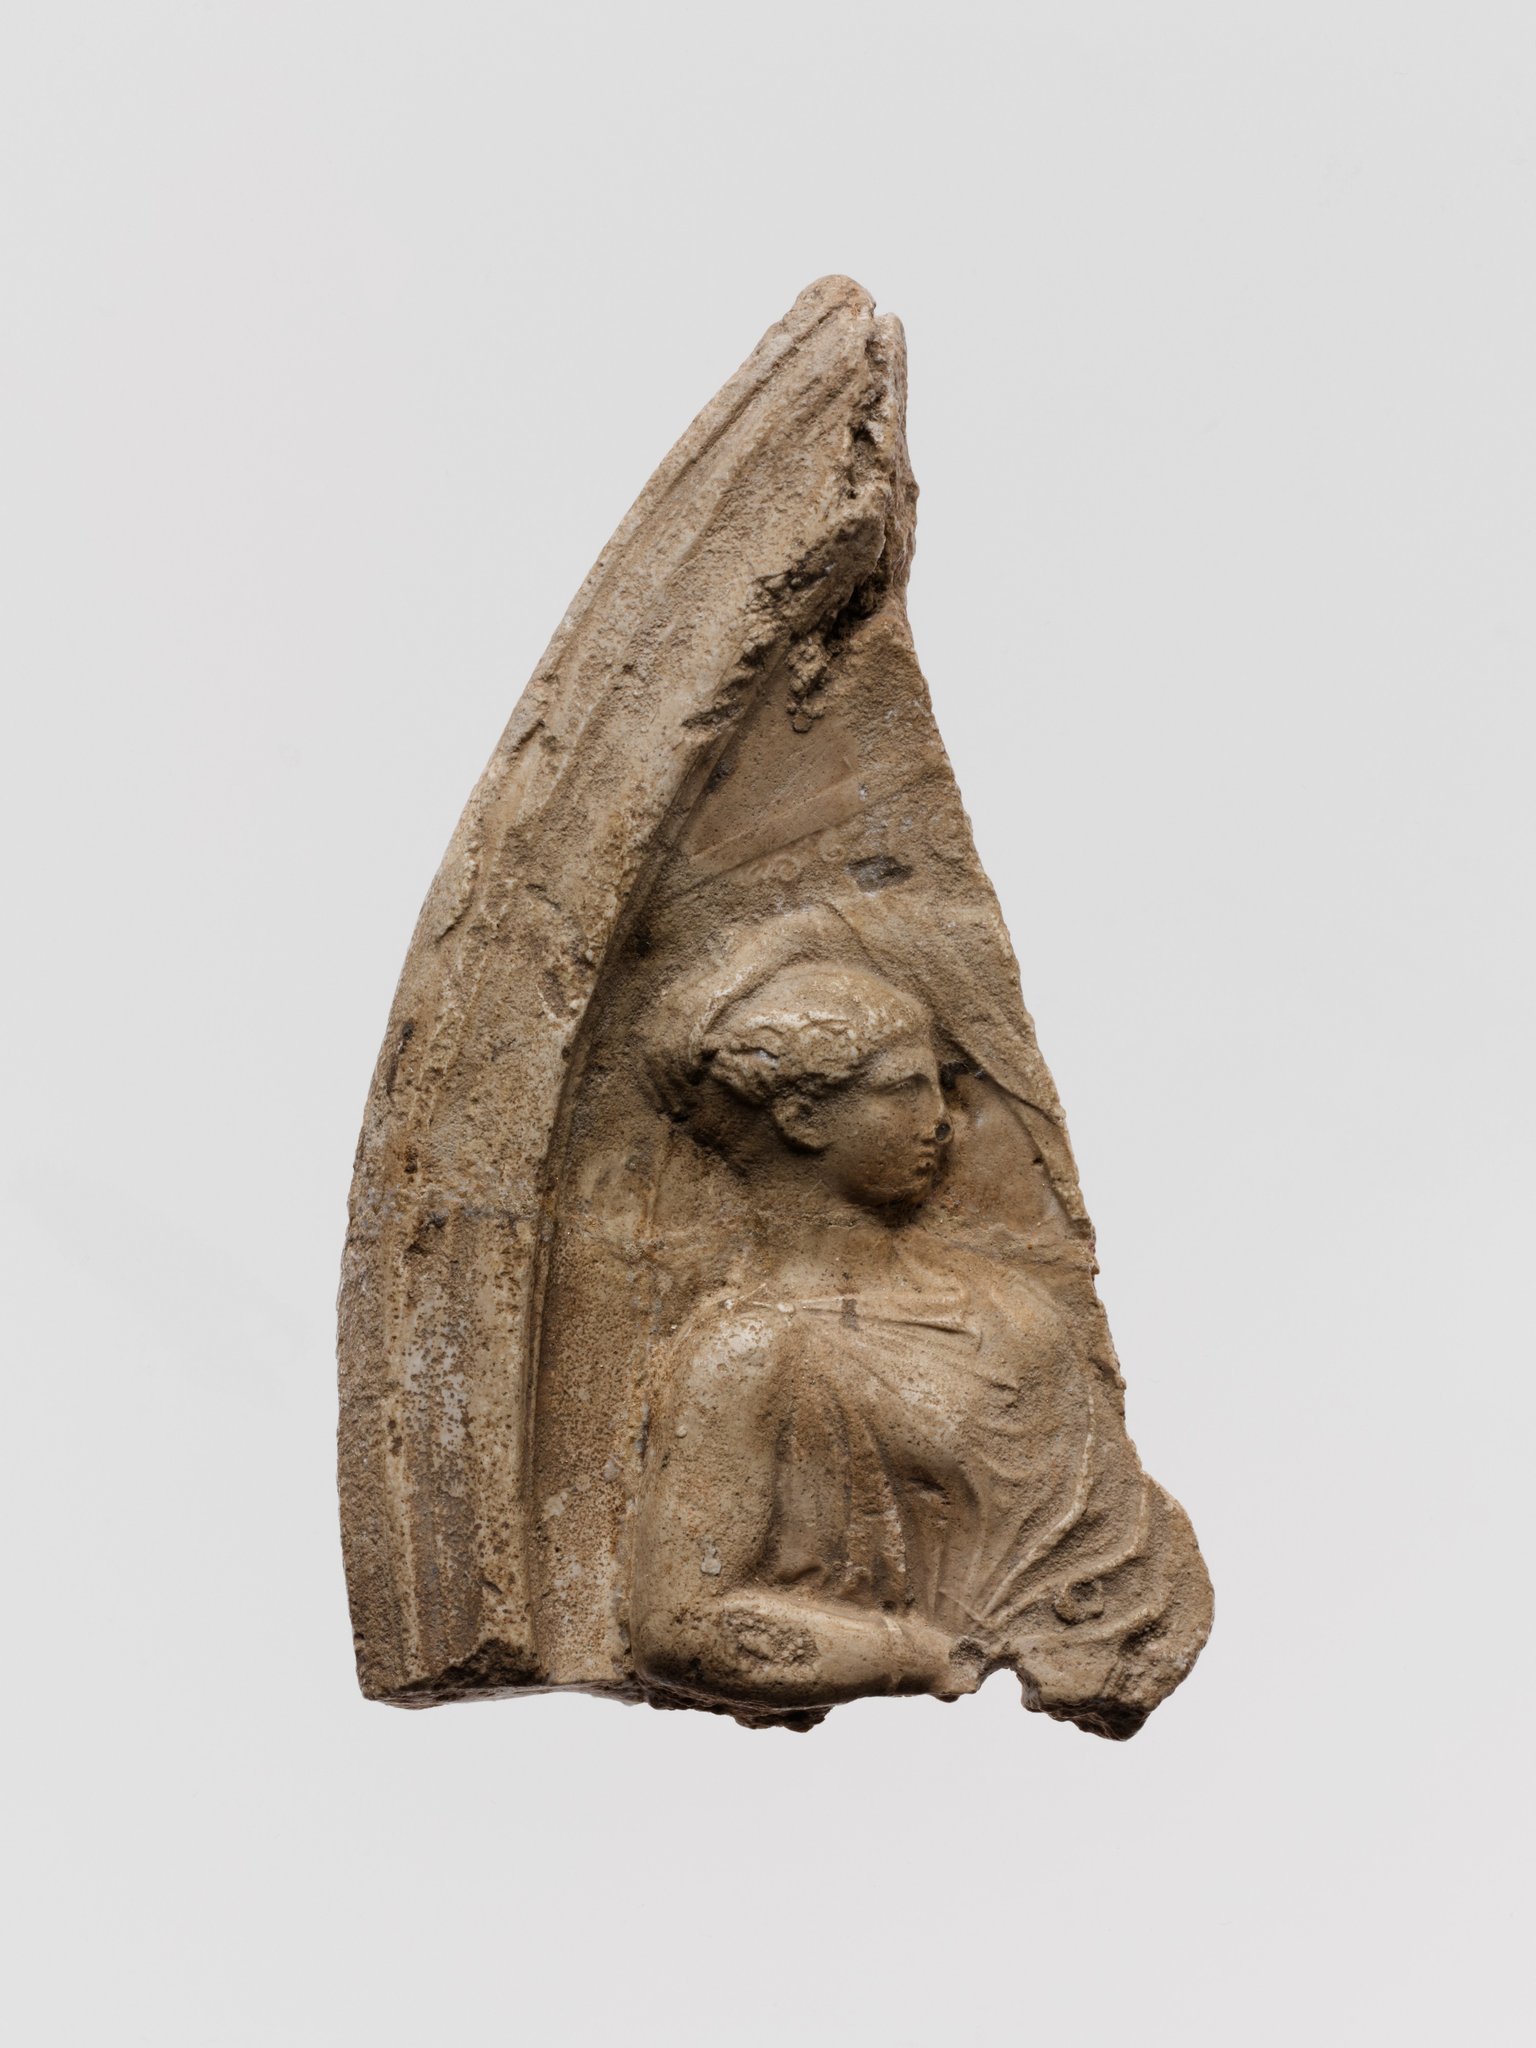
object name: mold of ancient cast for metal relief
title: Plaster relief fragment with a reclining woman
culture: roman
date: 1-100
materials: plaster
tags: women